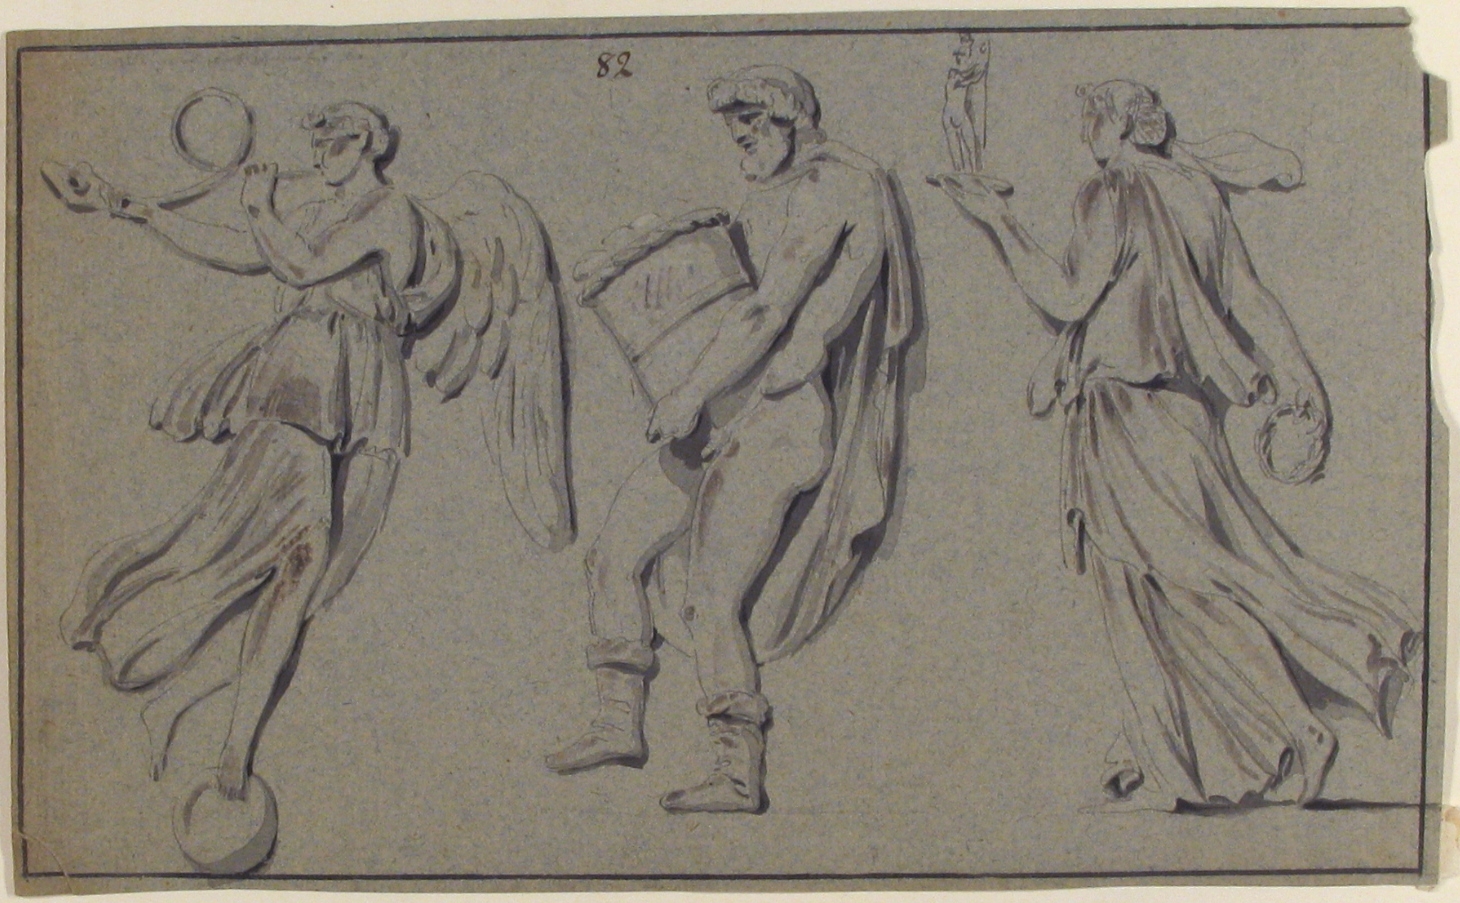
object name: drawing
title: Figures in Procession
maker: anonymous, french, 18th century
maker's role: artist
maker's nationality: french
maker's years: 1700-1800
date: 1701-1800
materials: ink, paper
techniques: brush, pen, wash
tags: musical instruments,male nudes,women